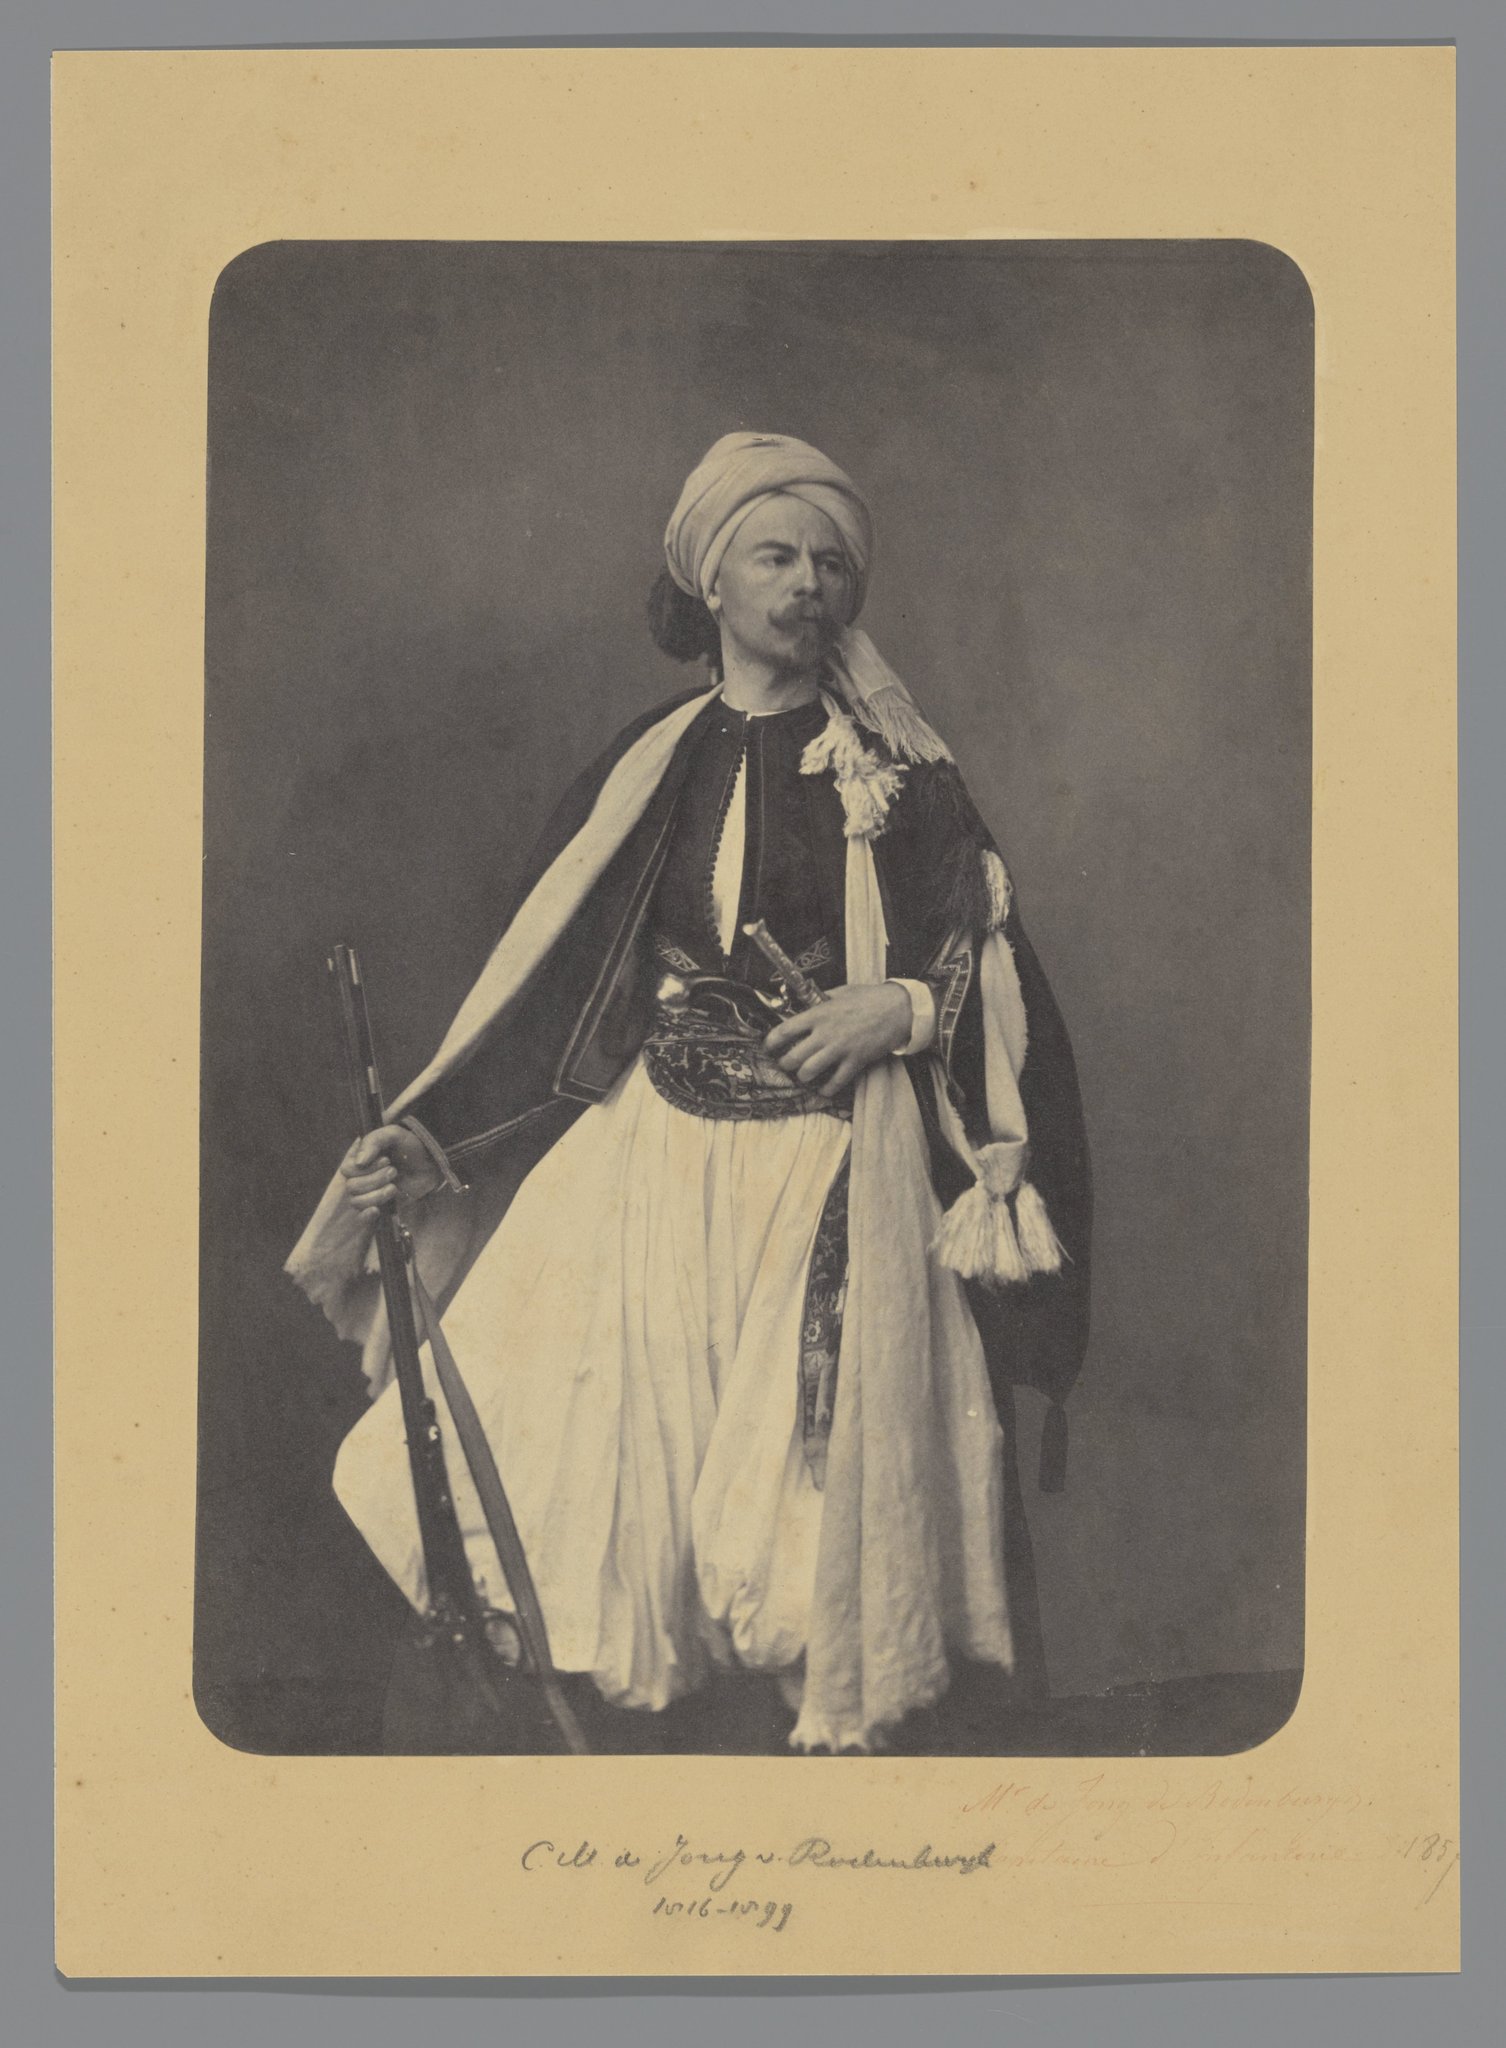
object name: photograph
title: C.M. de Jong v. Rodenburgh 1816-1899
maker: Anonymous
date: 1853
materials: cardboard, paper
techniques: salted paper print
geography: algeria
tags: haarlem, cornelius marius de jong van rodenburgh, historical persons, (military) uniforms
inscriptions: inscription: ‘Mr. de Jong de Rodenburgh/ Capitaine d'Infanterie 185[3?]’, collector's mark: Lugt 2228